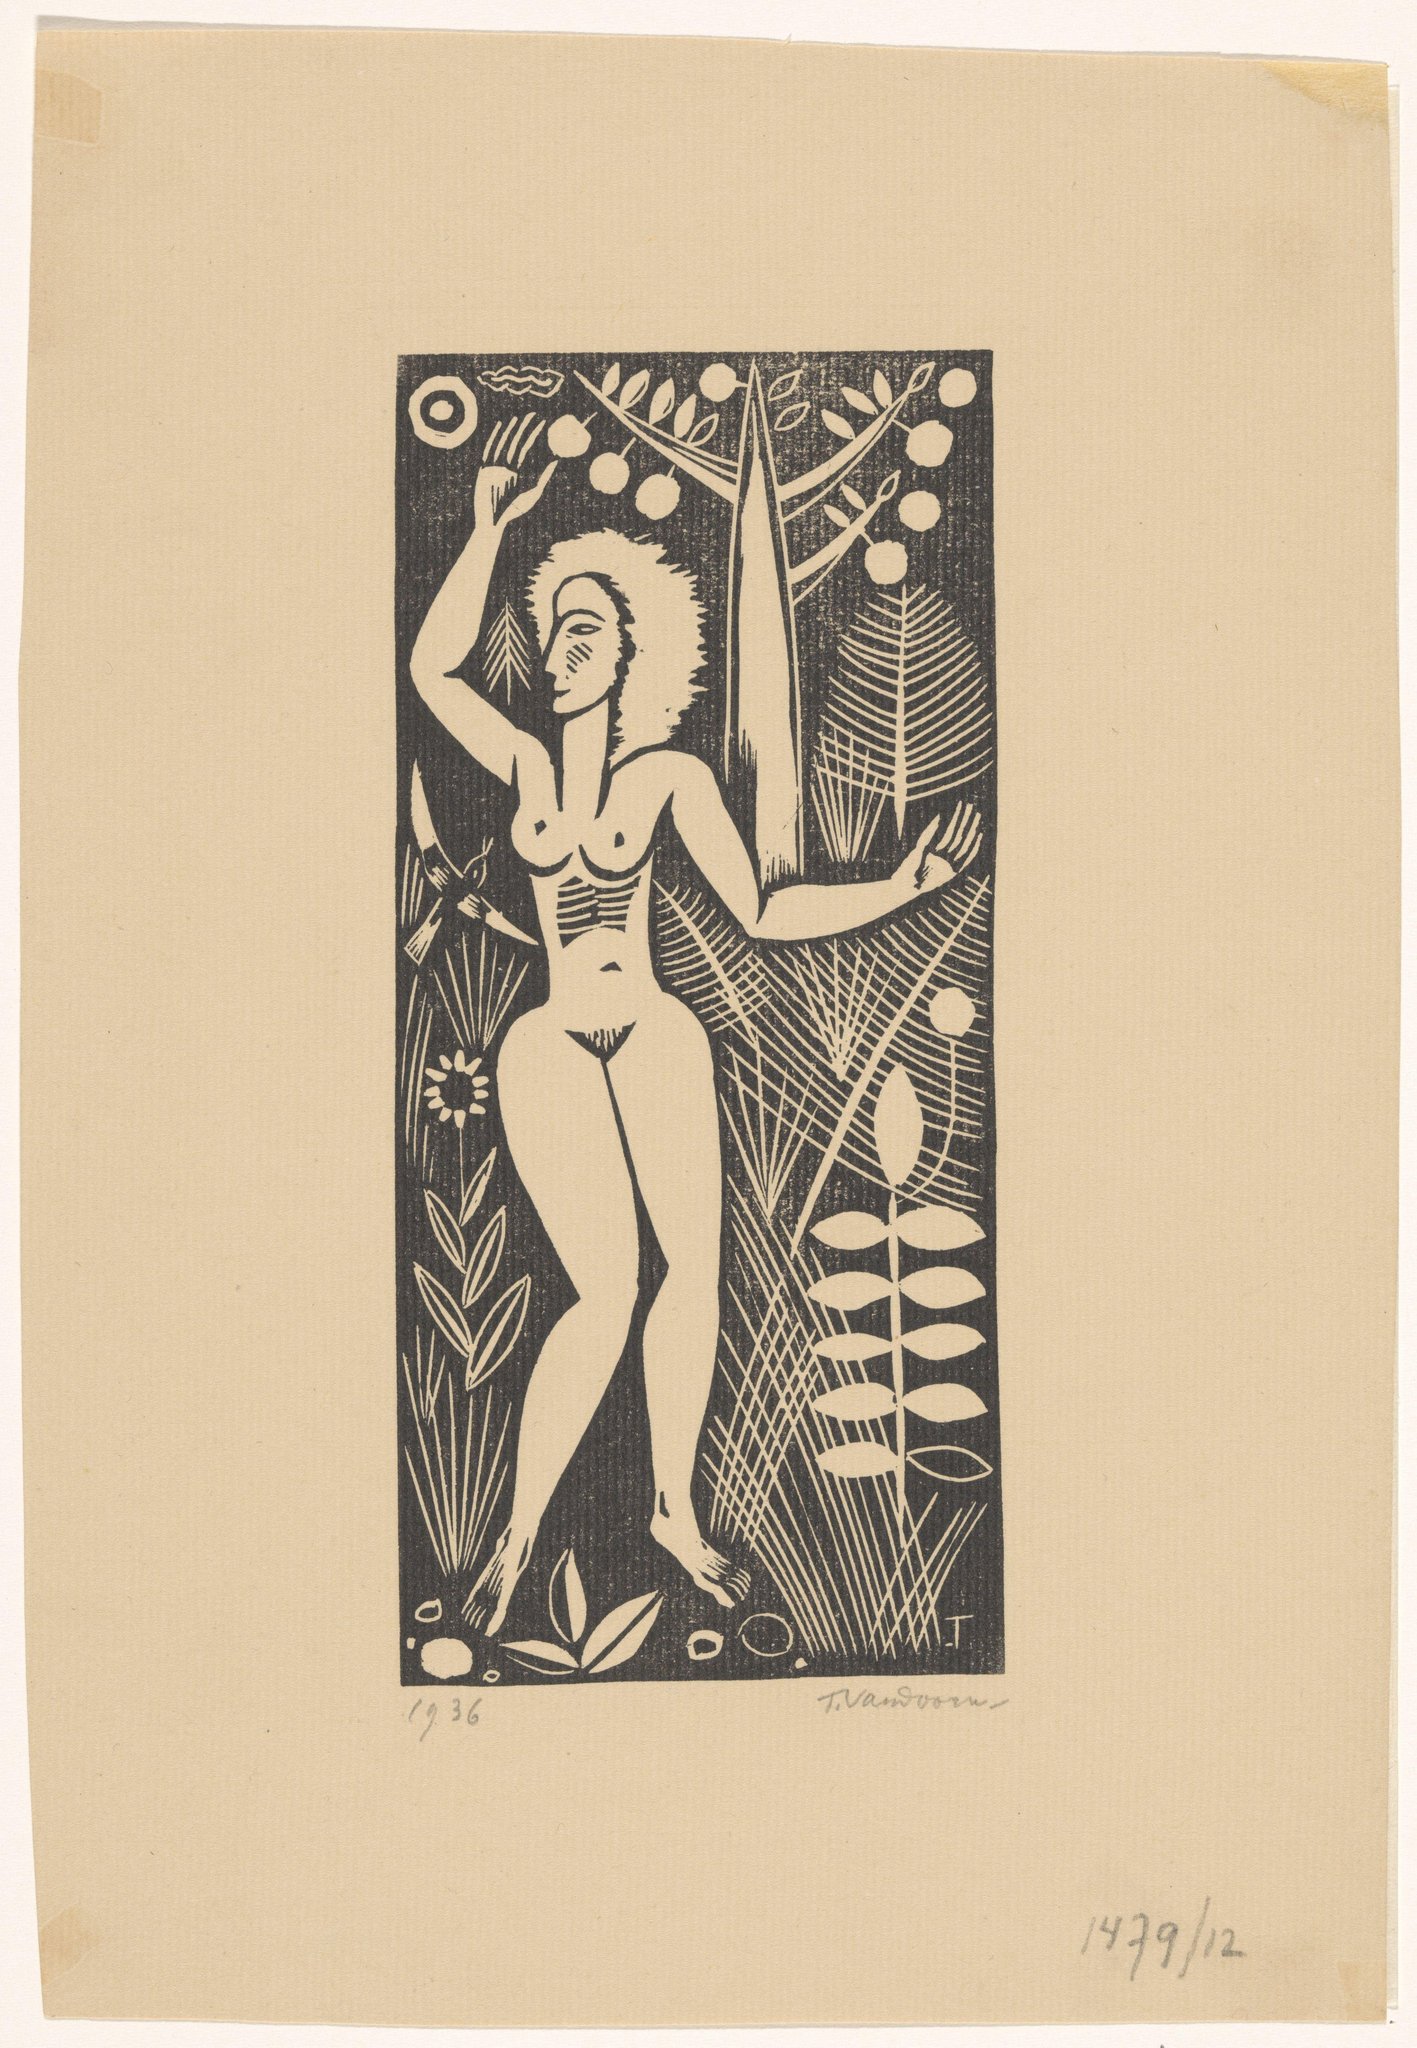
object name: print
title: Zonder titel (Vrouw in landschap)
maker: tinus van doorn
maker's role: painter, print maker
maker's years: 1905-1940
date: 1936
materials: paper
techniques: linocut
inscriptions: inscription: ‘1936’, monogram: ‘T’, signature: ‘T. van Doorn’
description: Een vrouwelijk naakt staat met haar rechter arm opgeheven, reikend naar vruchten aan de fruitboom achter haar, in een natuurlijke omgeving met planten, bloem en vogel.